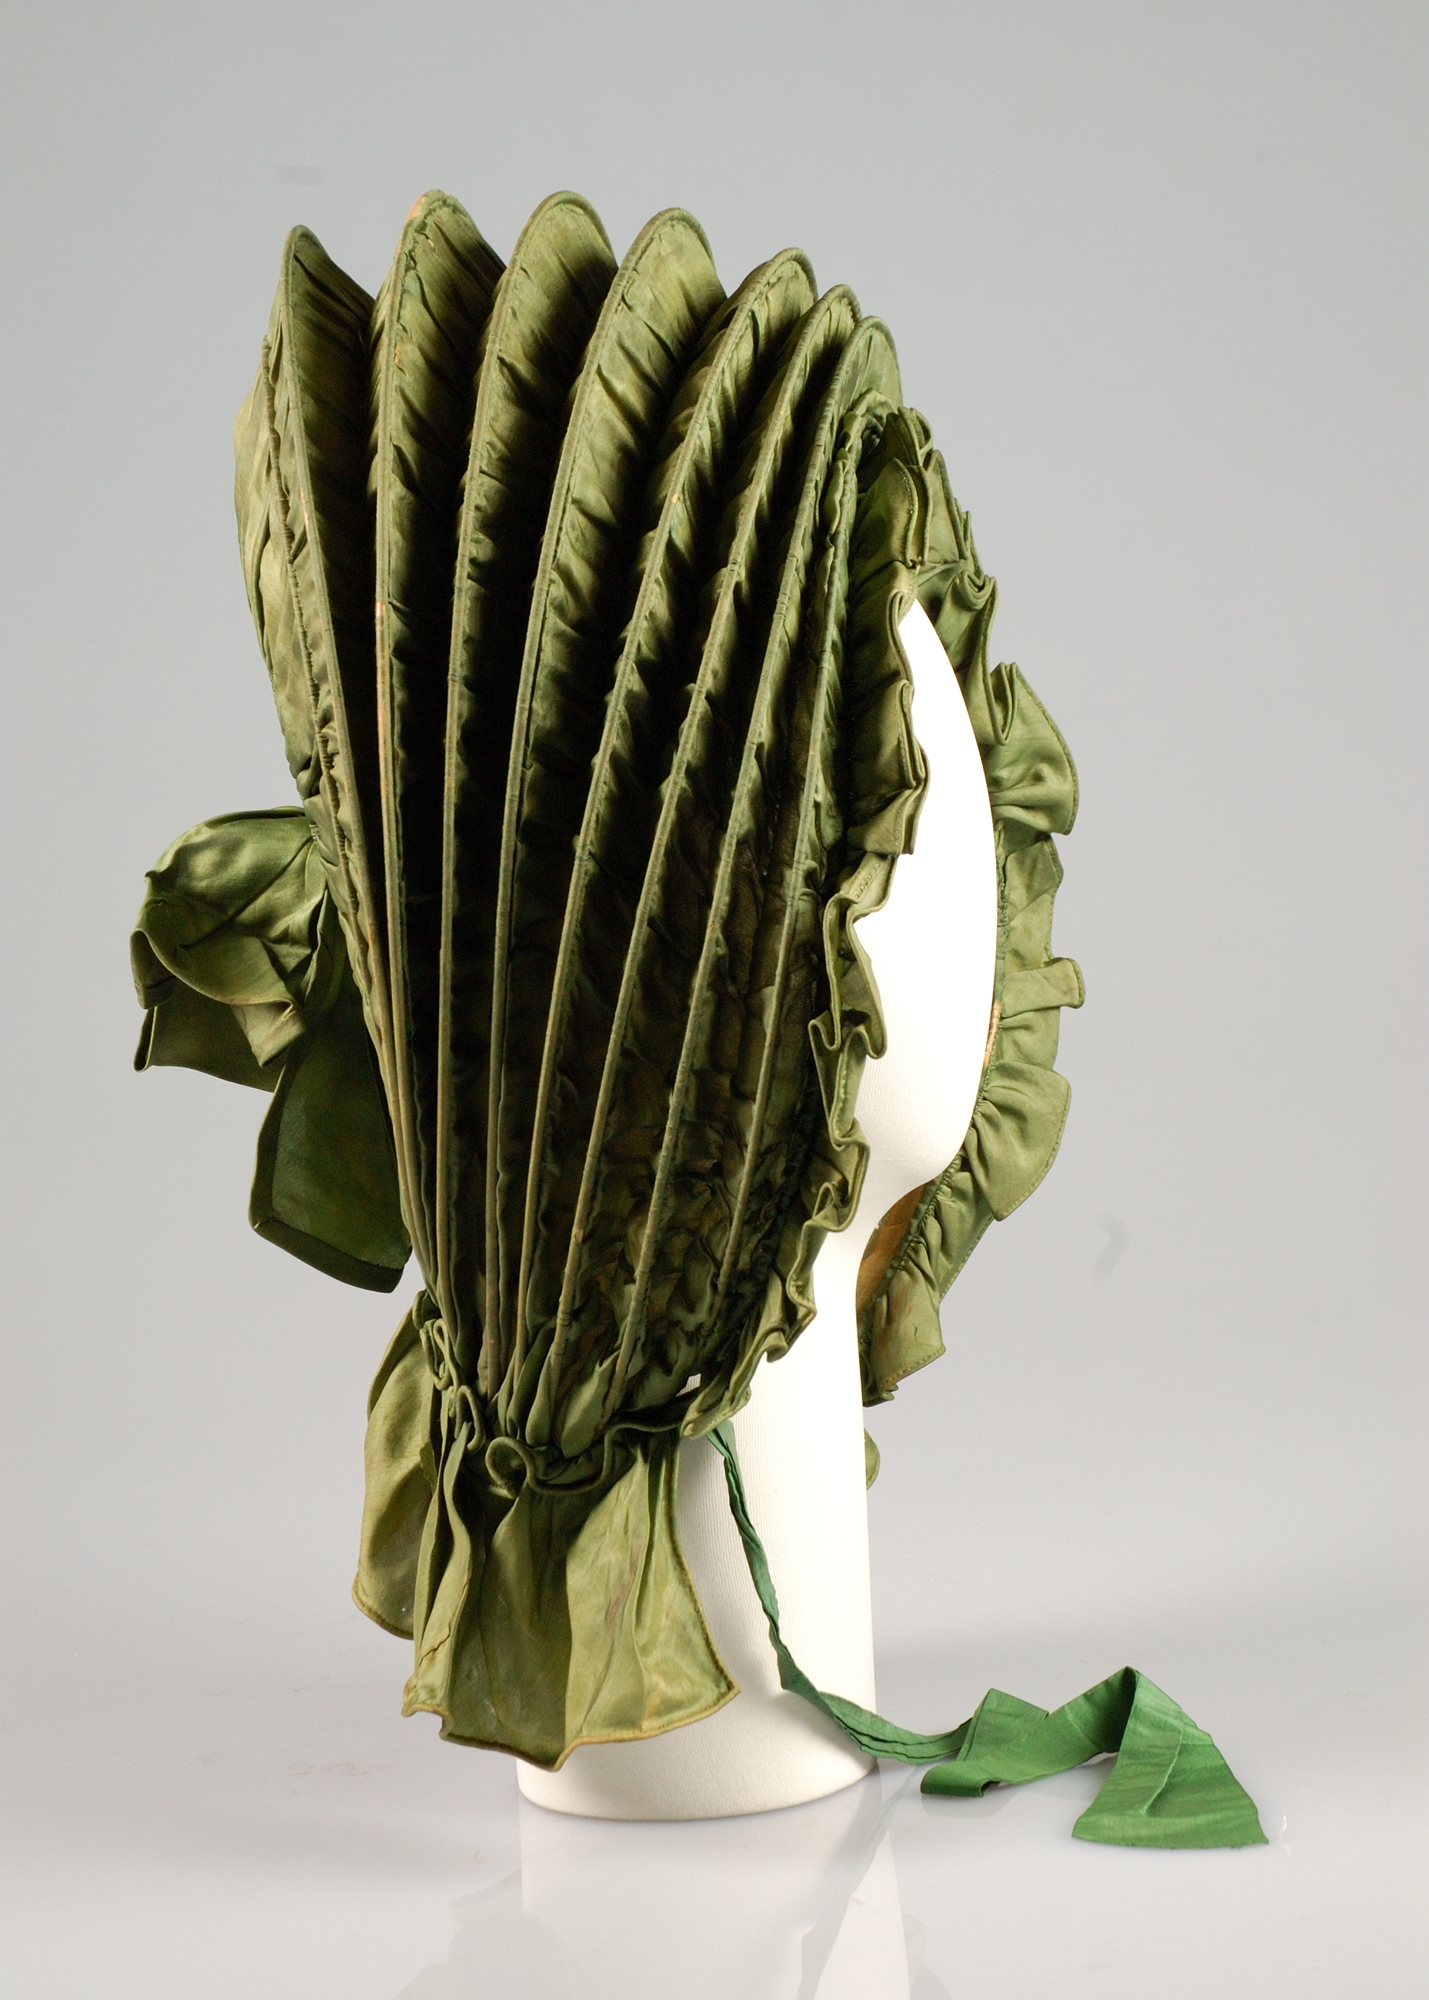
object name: calash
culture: american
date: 1830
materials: silk